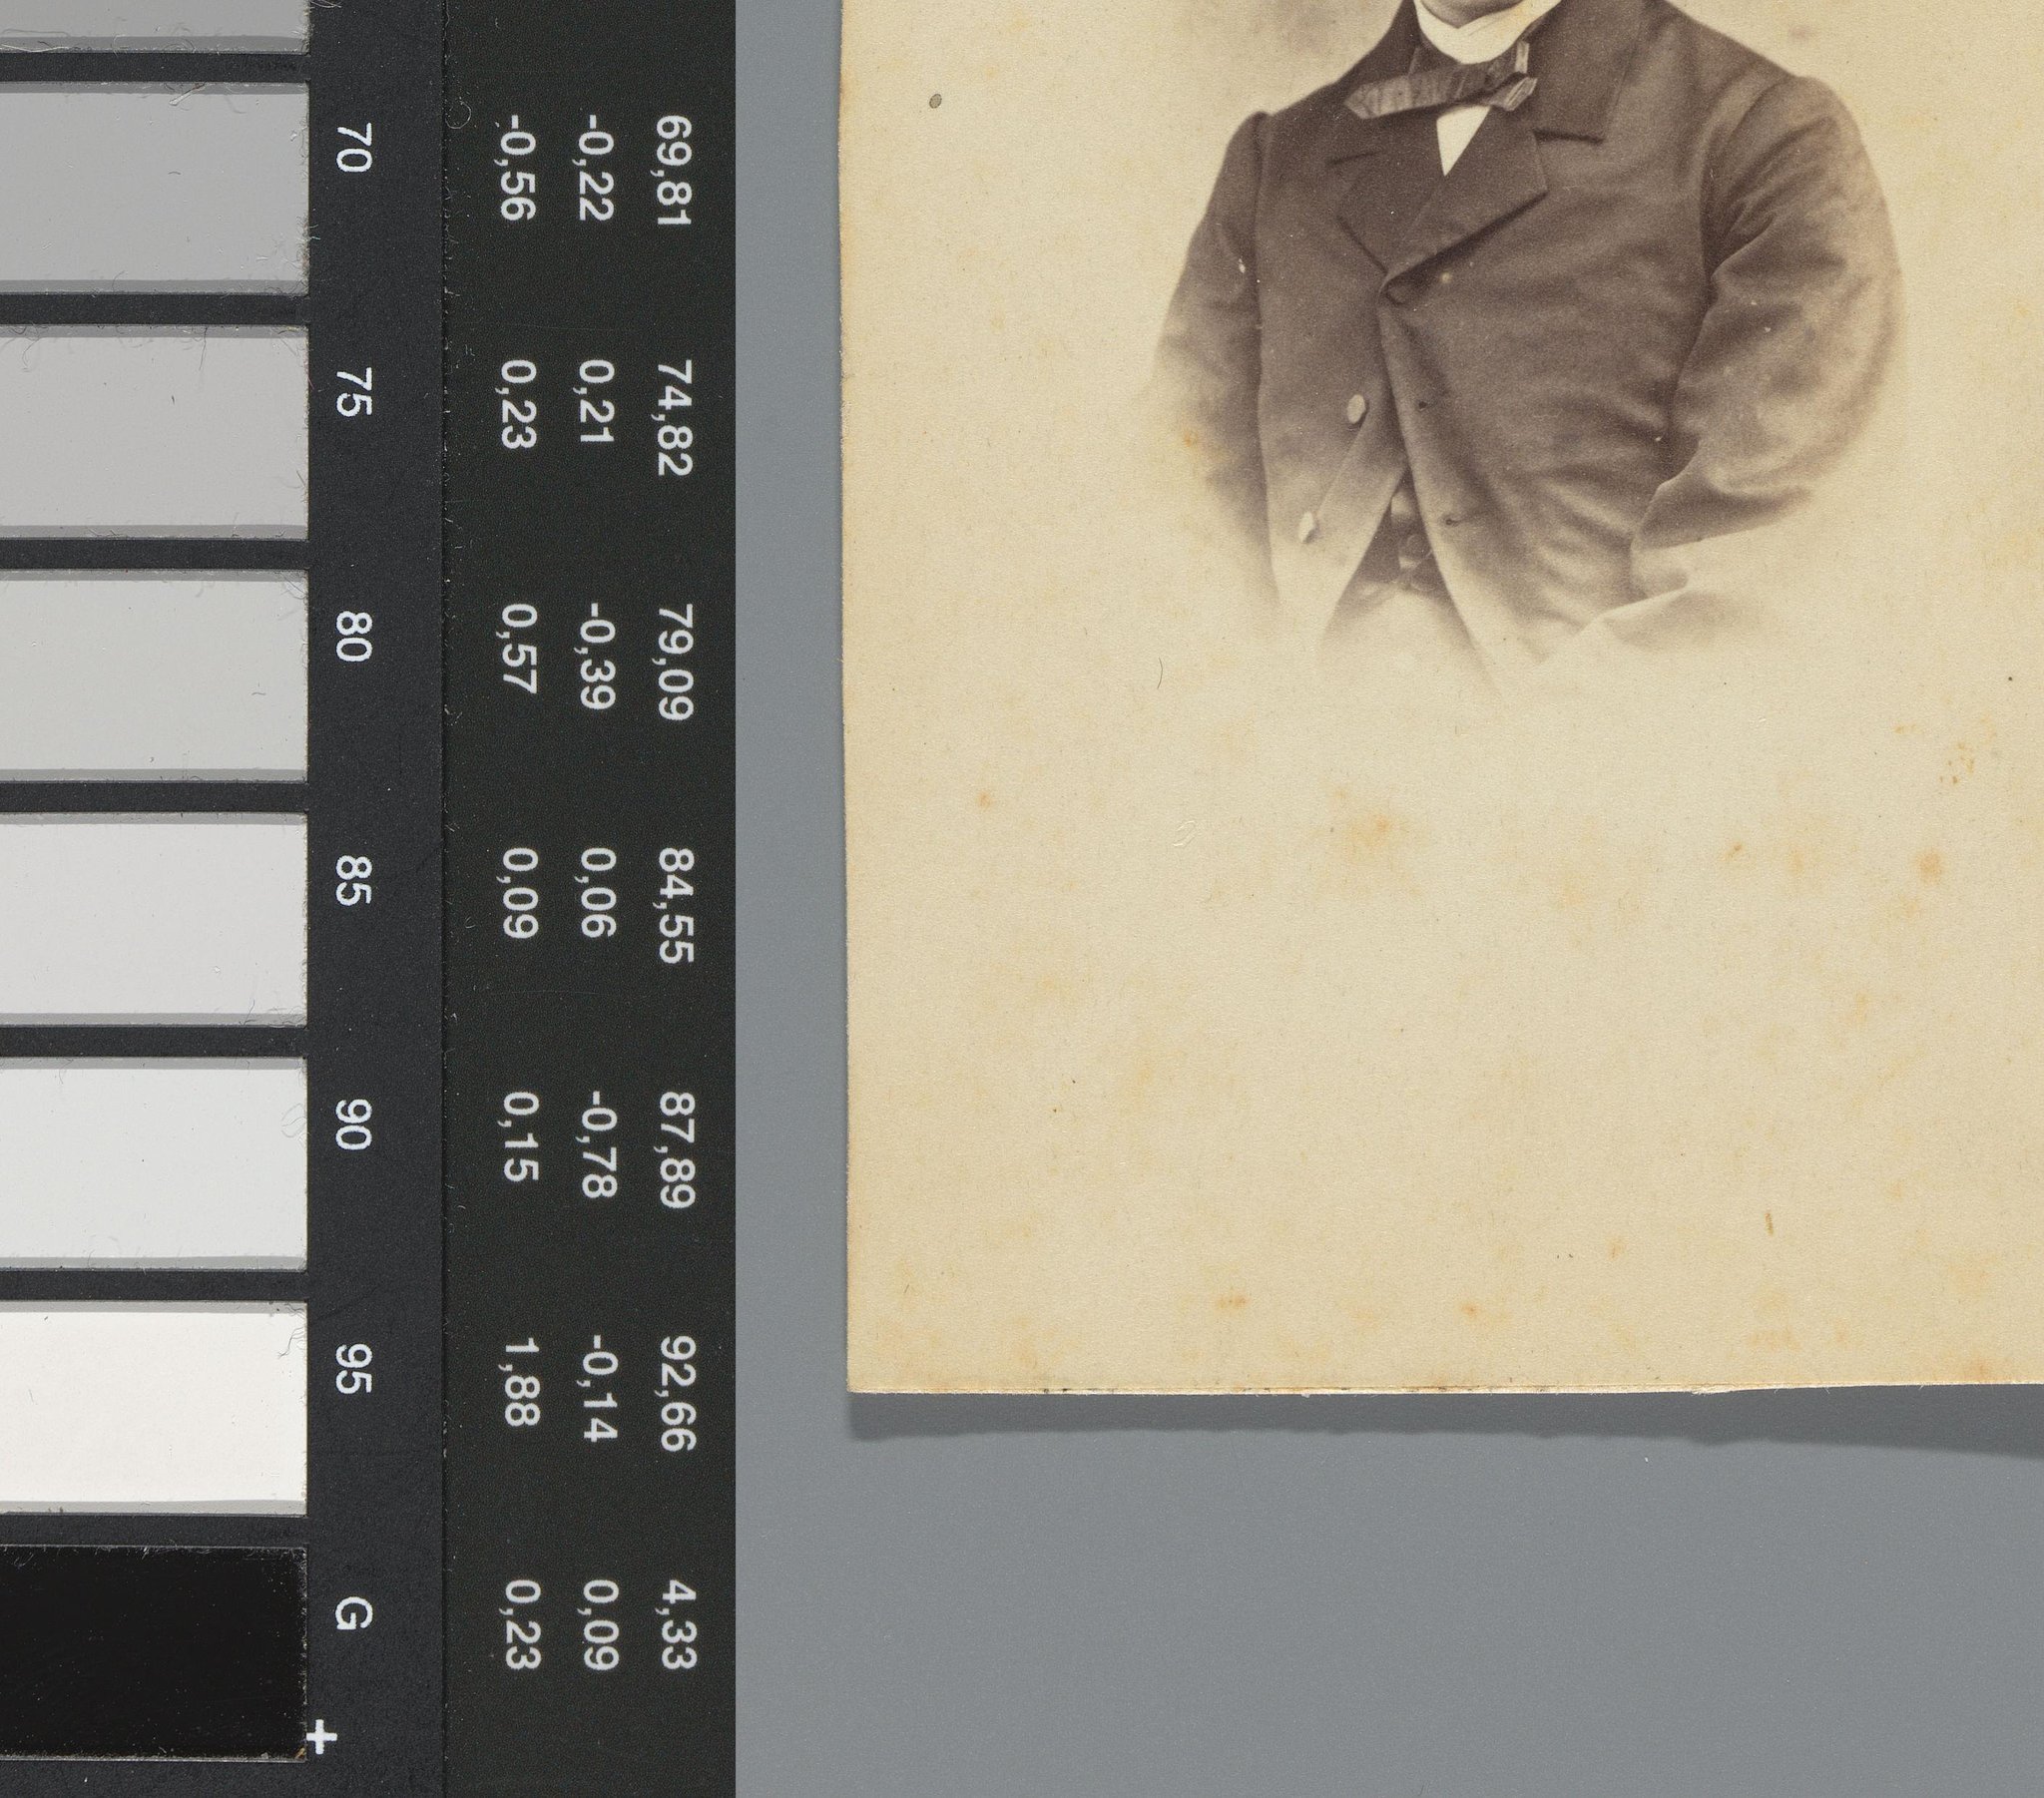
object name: photograph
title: Portret van Carolus Petrus van den Berg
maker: a. böeseken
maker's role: fotograaf, lithograaf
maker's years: 1834-1919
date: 1855-1910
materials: cardboard, photographic support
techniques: albumen print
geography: rotterdam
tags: carolus petrus van den berg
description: Staande man ten voeten uit met een brief in de hand leunend op een sokkel.